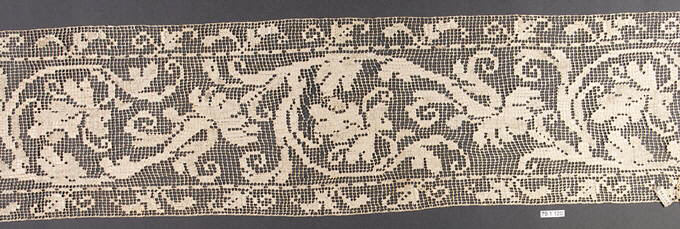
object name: border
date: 1501-1700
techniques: embroidery